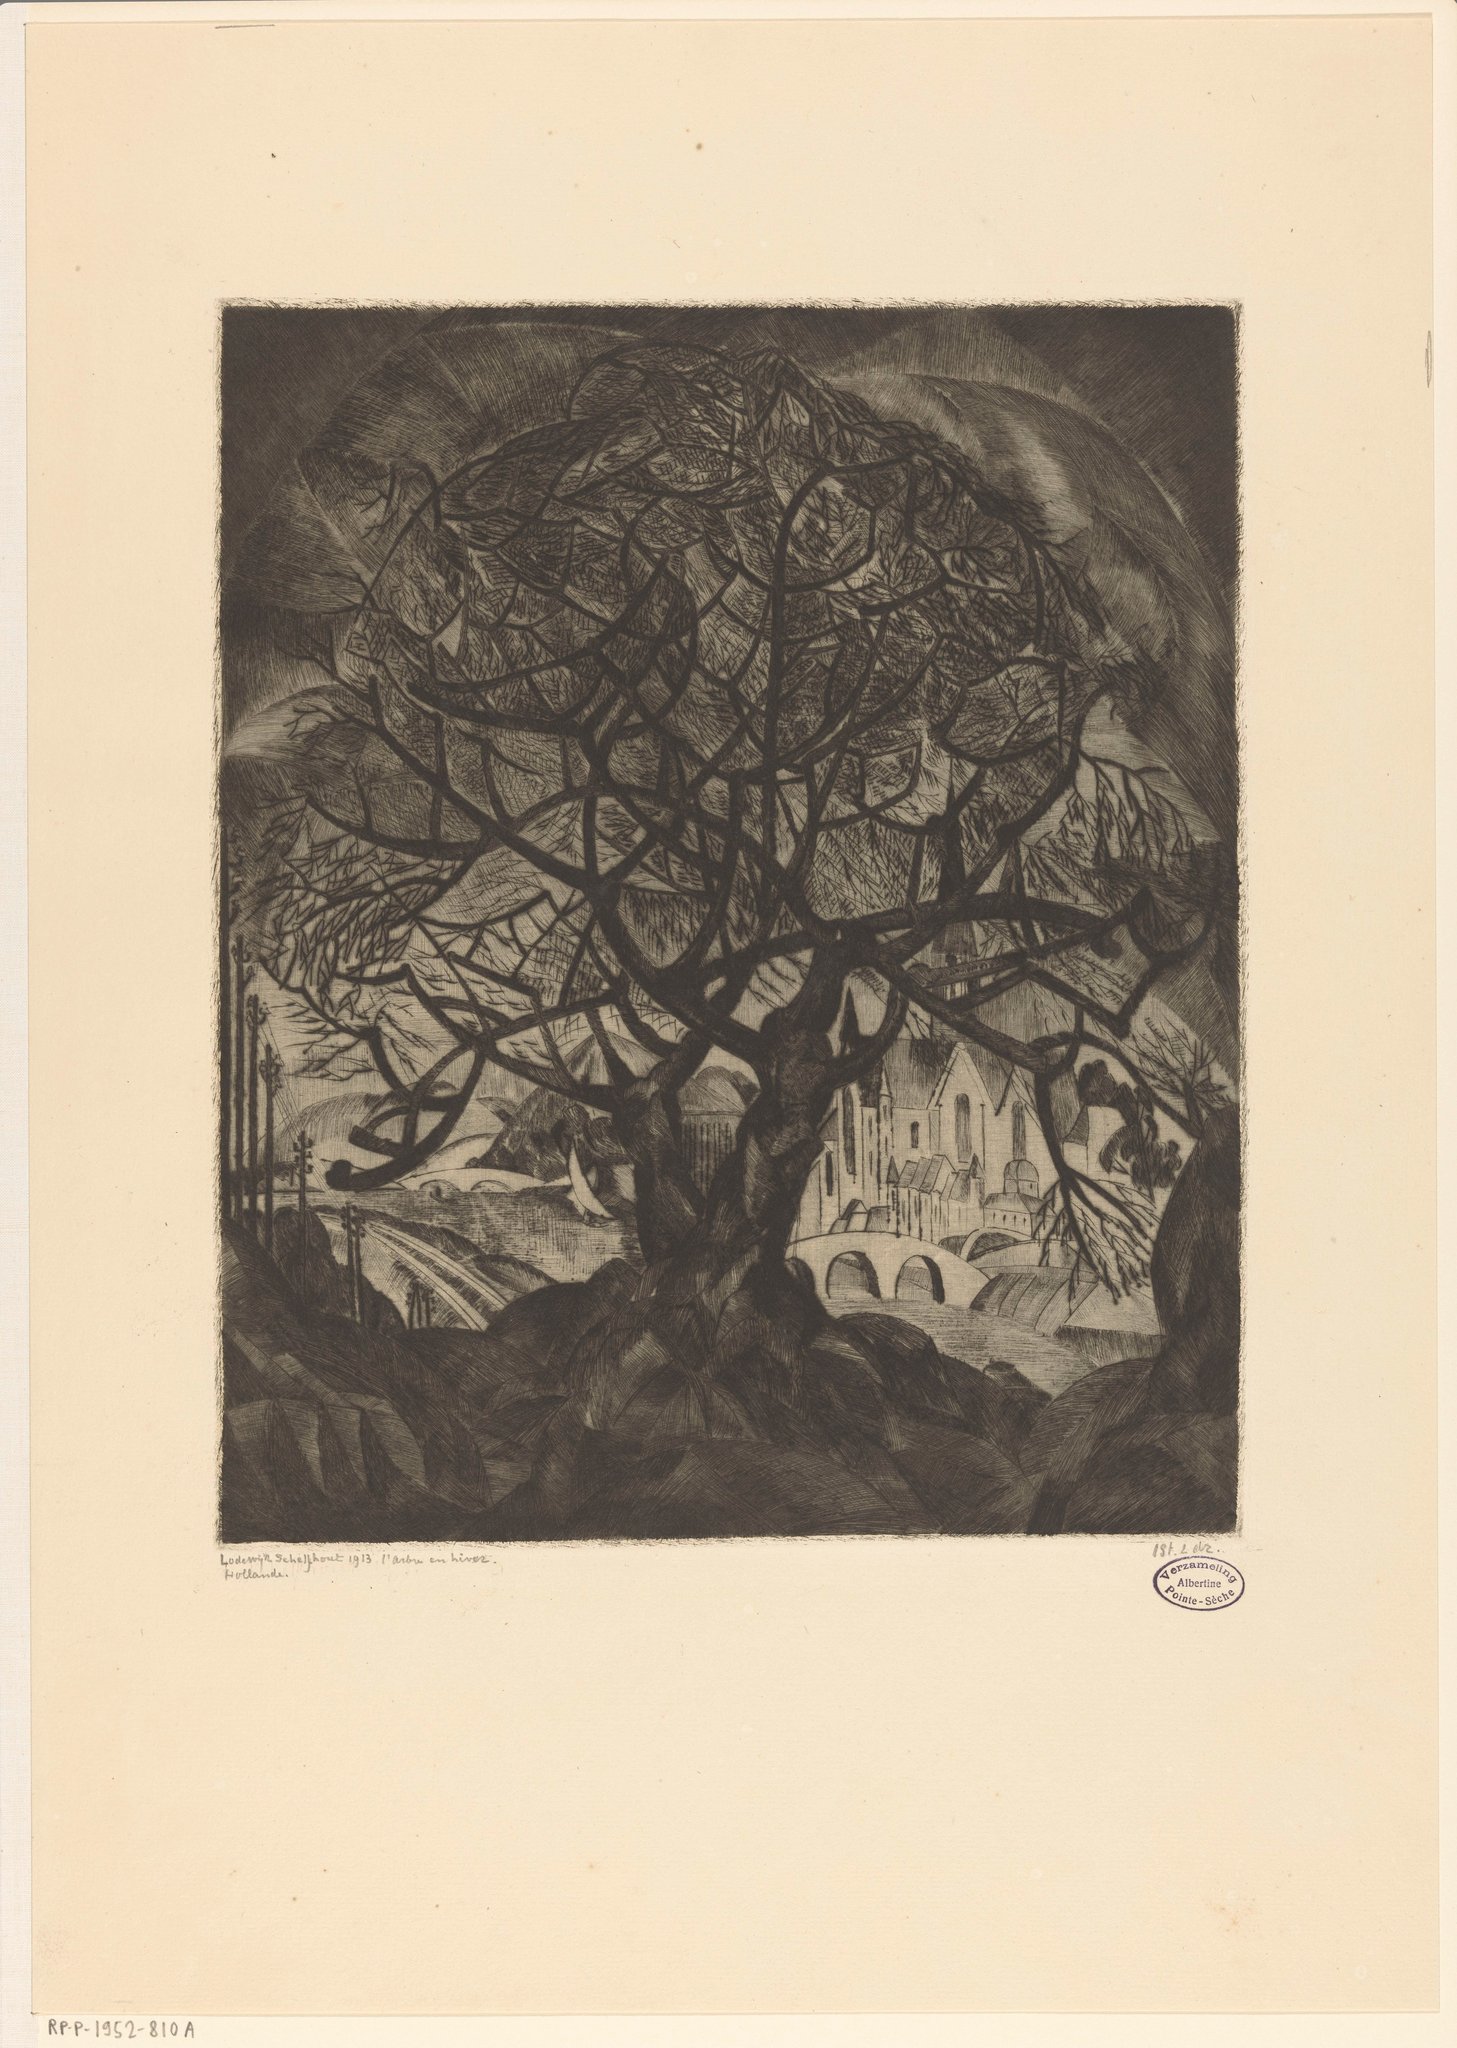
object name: print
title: L'Arbre en hiver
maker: lodewijk schelfhout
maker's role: draughtsman, print maker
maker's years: 1881-1943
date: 1913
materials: paper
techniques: drypoint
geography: netherlands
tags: trees (+ bare plant), village, pylons, power lines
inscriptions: collector's mark: Lugt 5i, collector's mark: Lugt 2760, collector's mark: Lugt 2228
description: Op de achtergrond een heuvellandschap met elektriciteitsmasten, een meer, bruggen en een nederzetting met kerk.